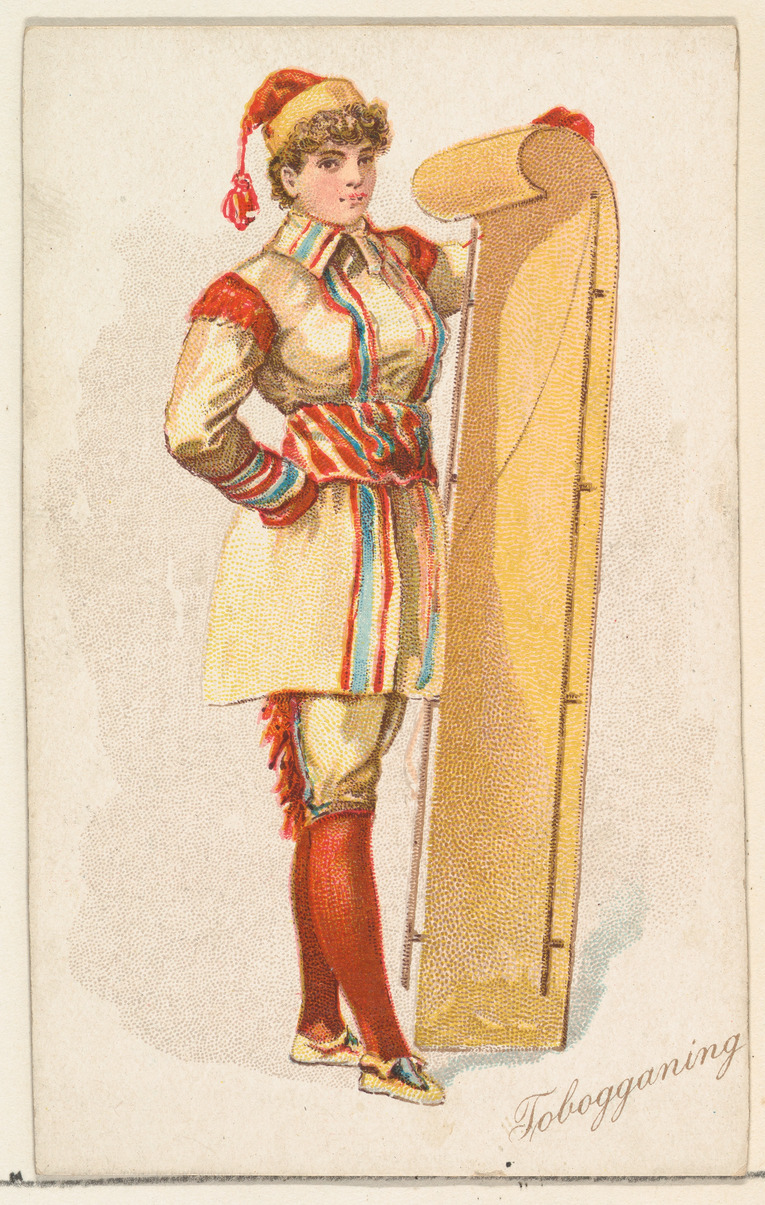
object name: print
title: Tobogganing, from the Pretty Athletes series (N196) issued by Wm. S. Kimball & Co.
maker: william s. kimball & company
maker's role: publisher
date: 1889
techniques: color lithograph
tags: women,athletes